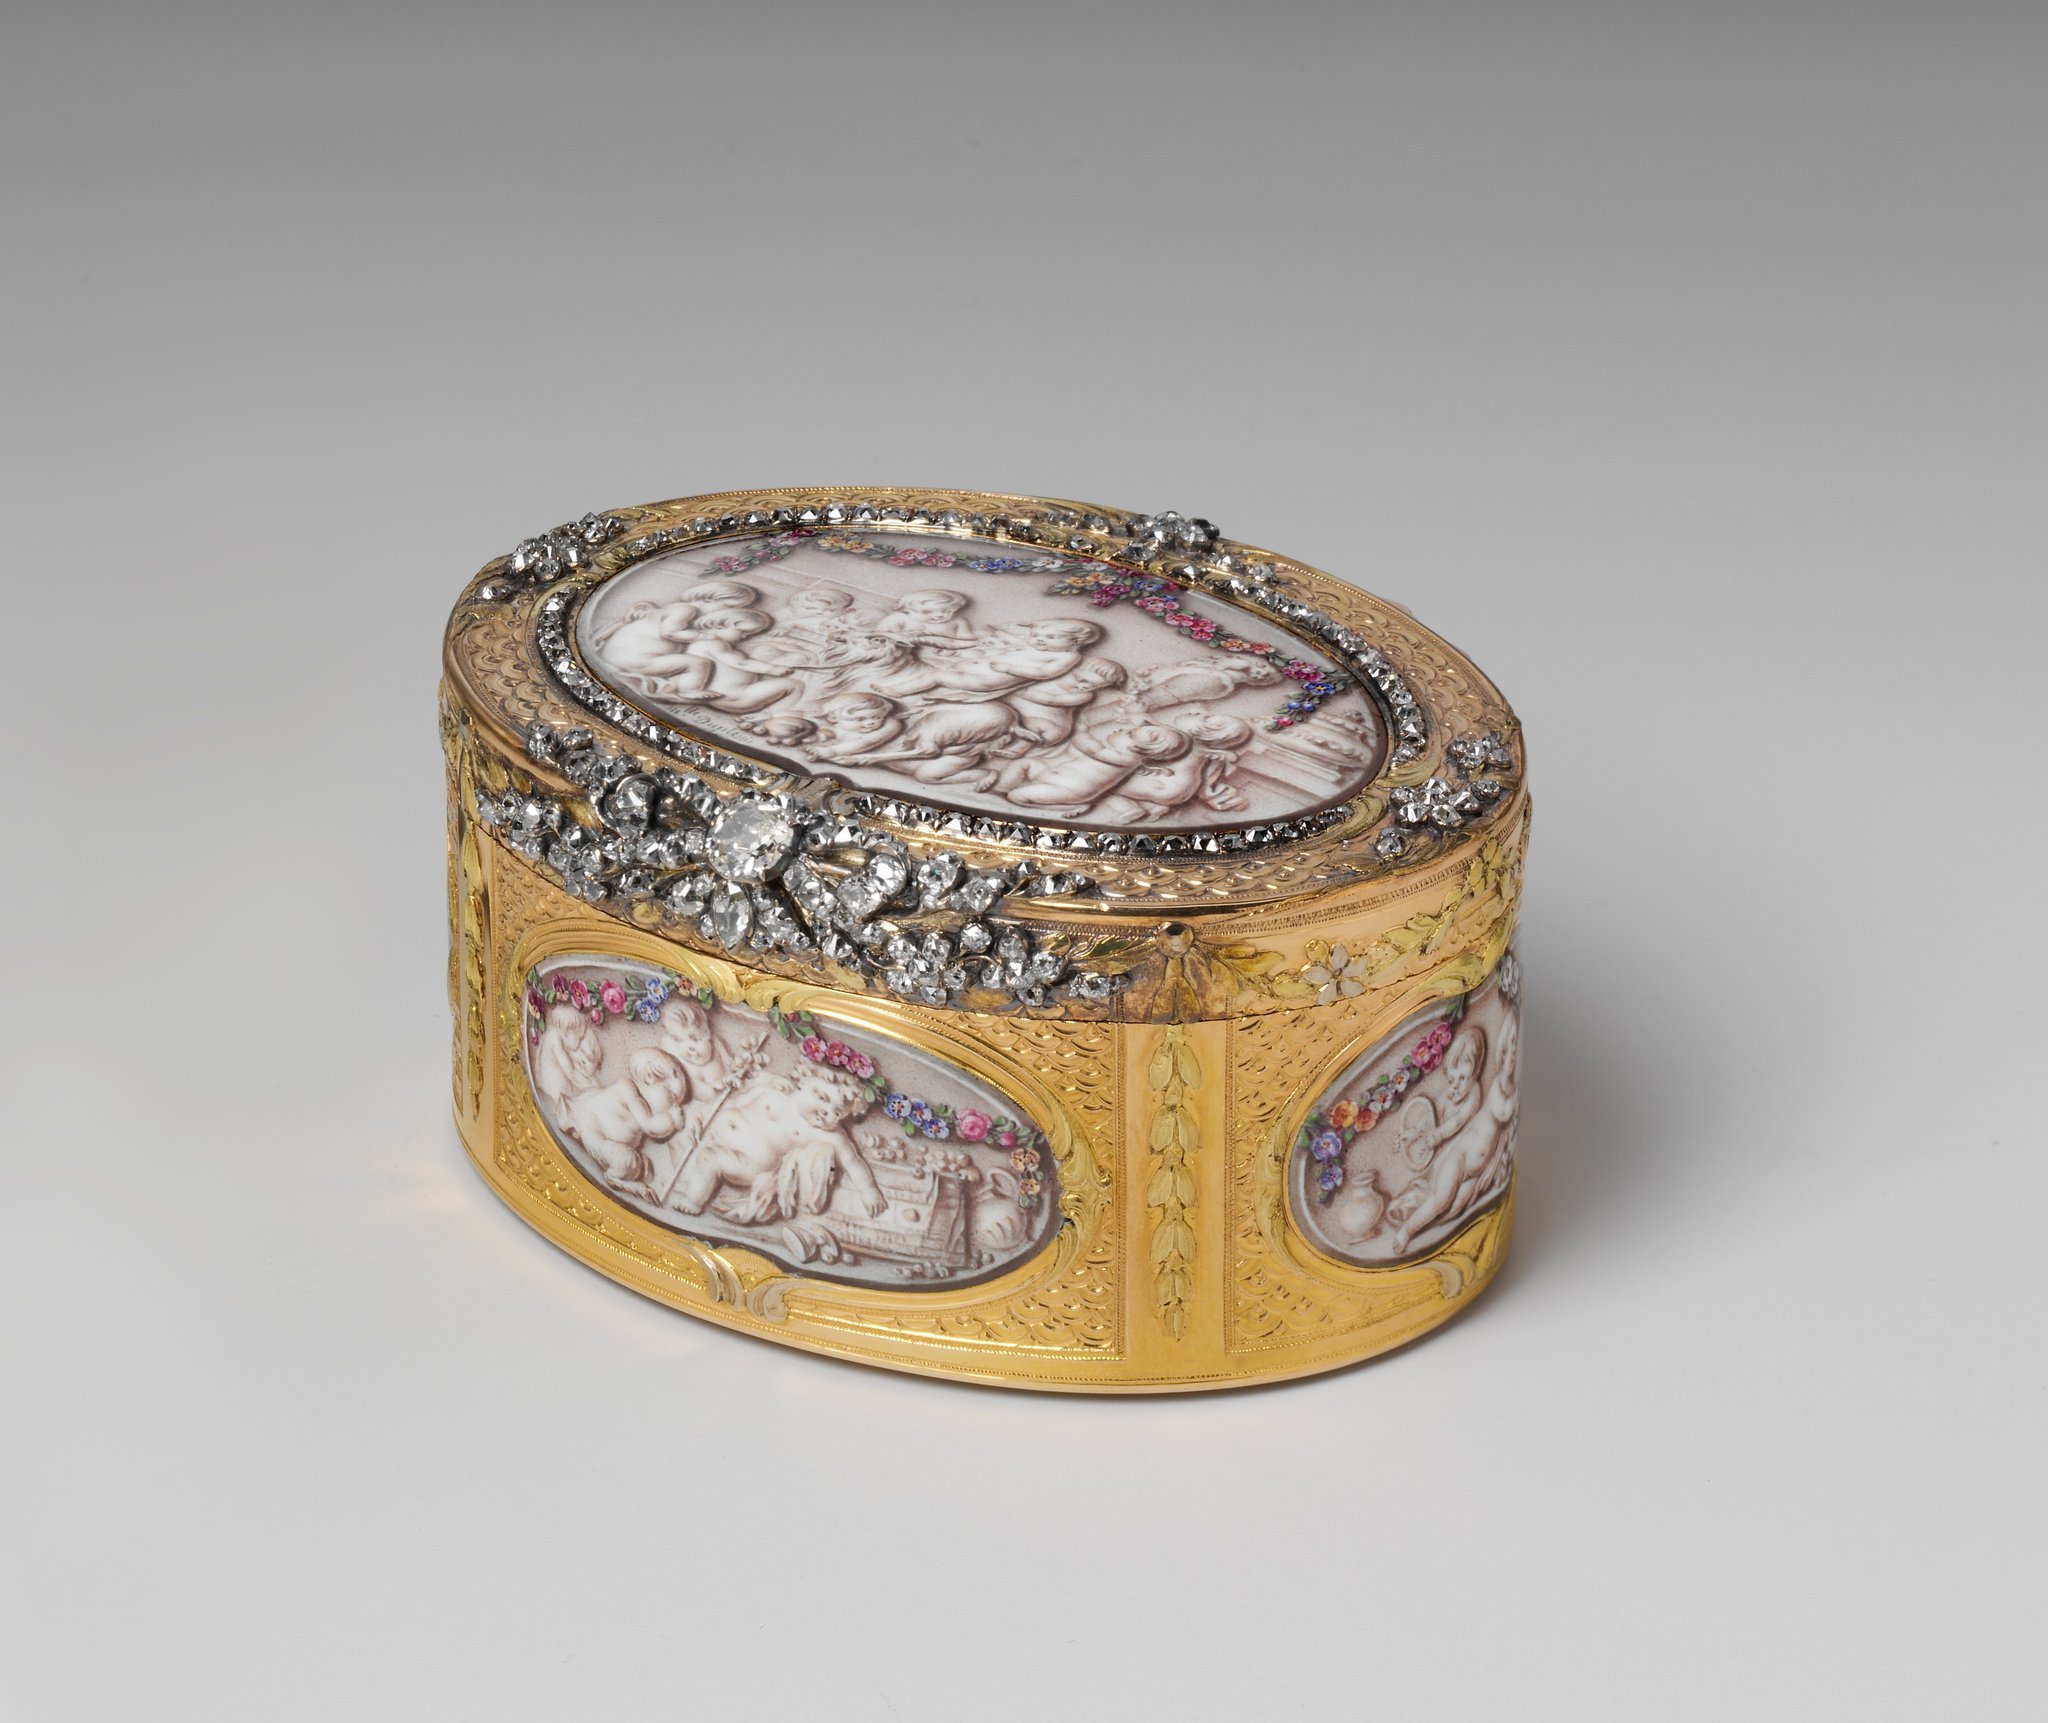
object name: snuffbox, painting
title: Snuffbox with six scenes of putti at play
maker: jean georges (or george)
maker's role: maker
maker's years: 1665-1765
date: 1761-1762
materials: diamond, enamel, gold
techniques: grisaille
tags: putti